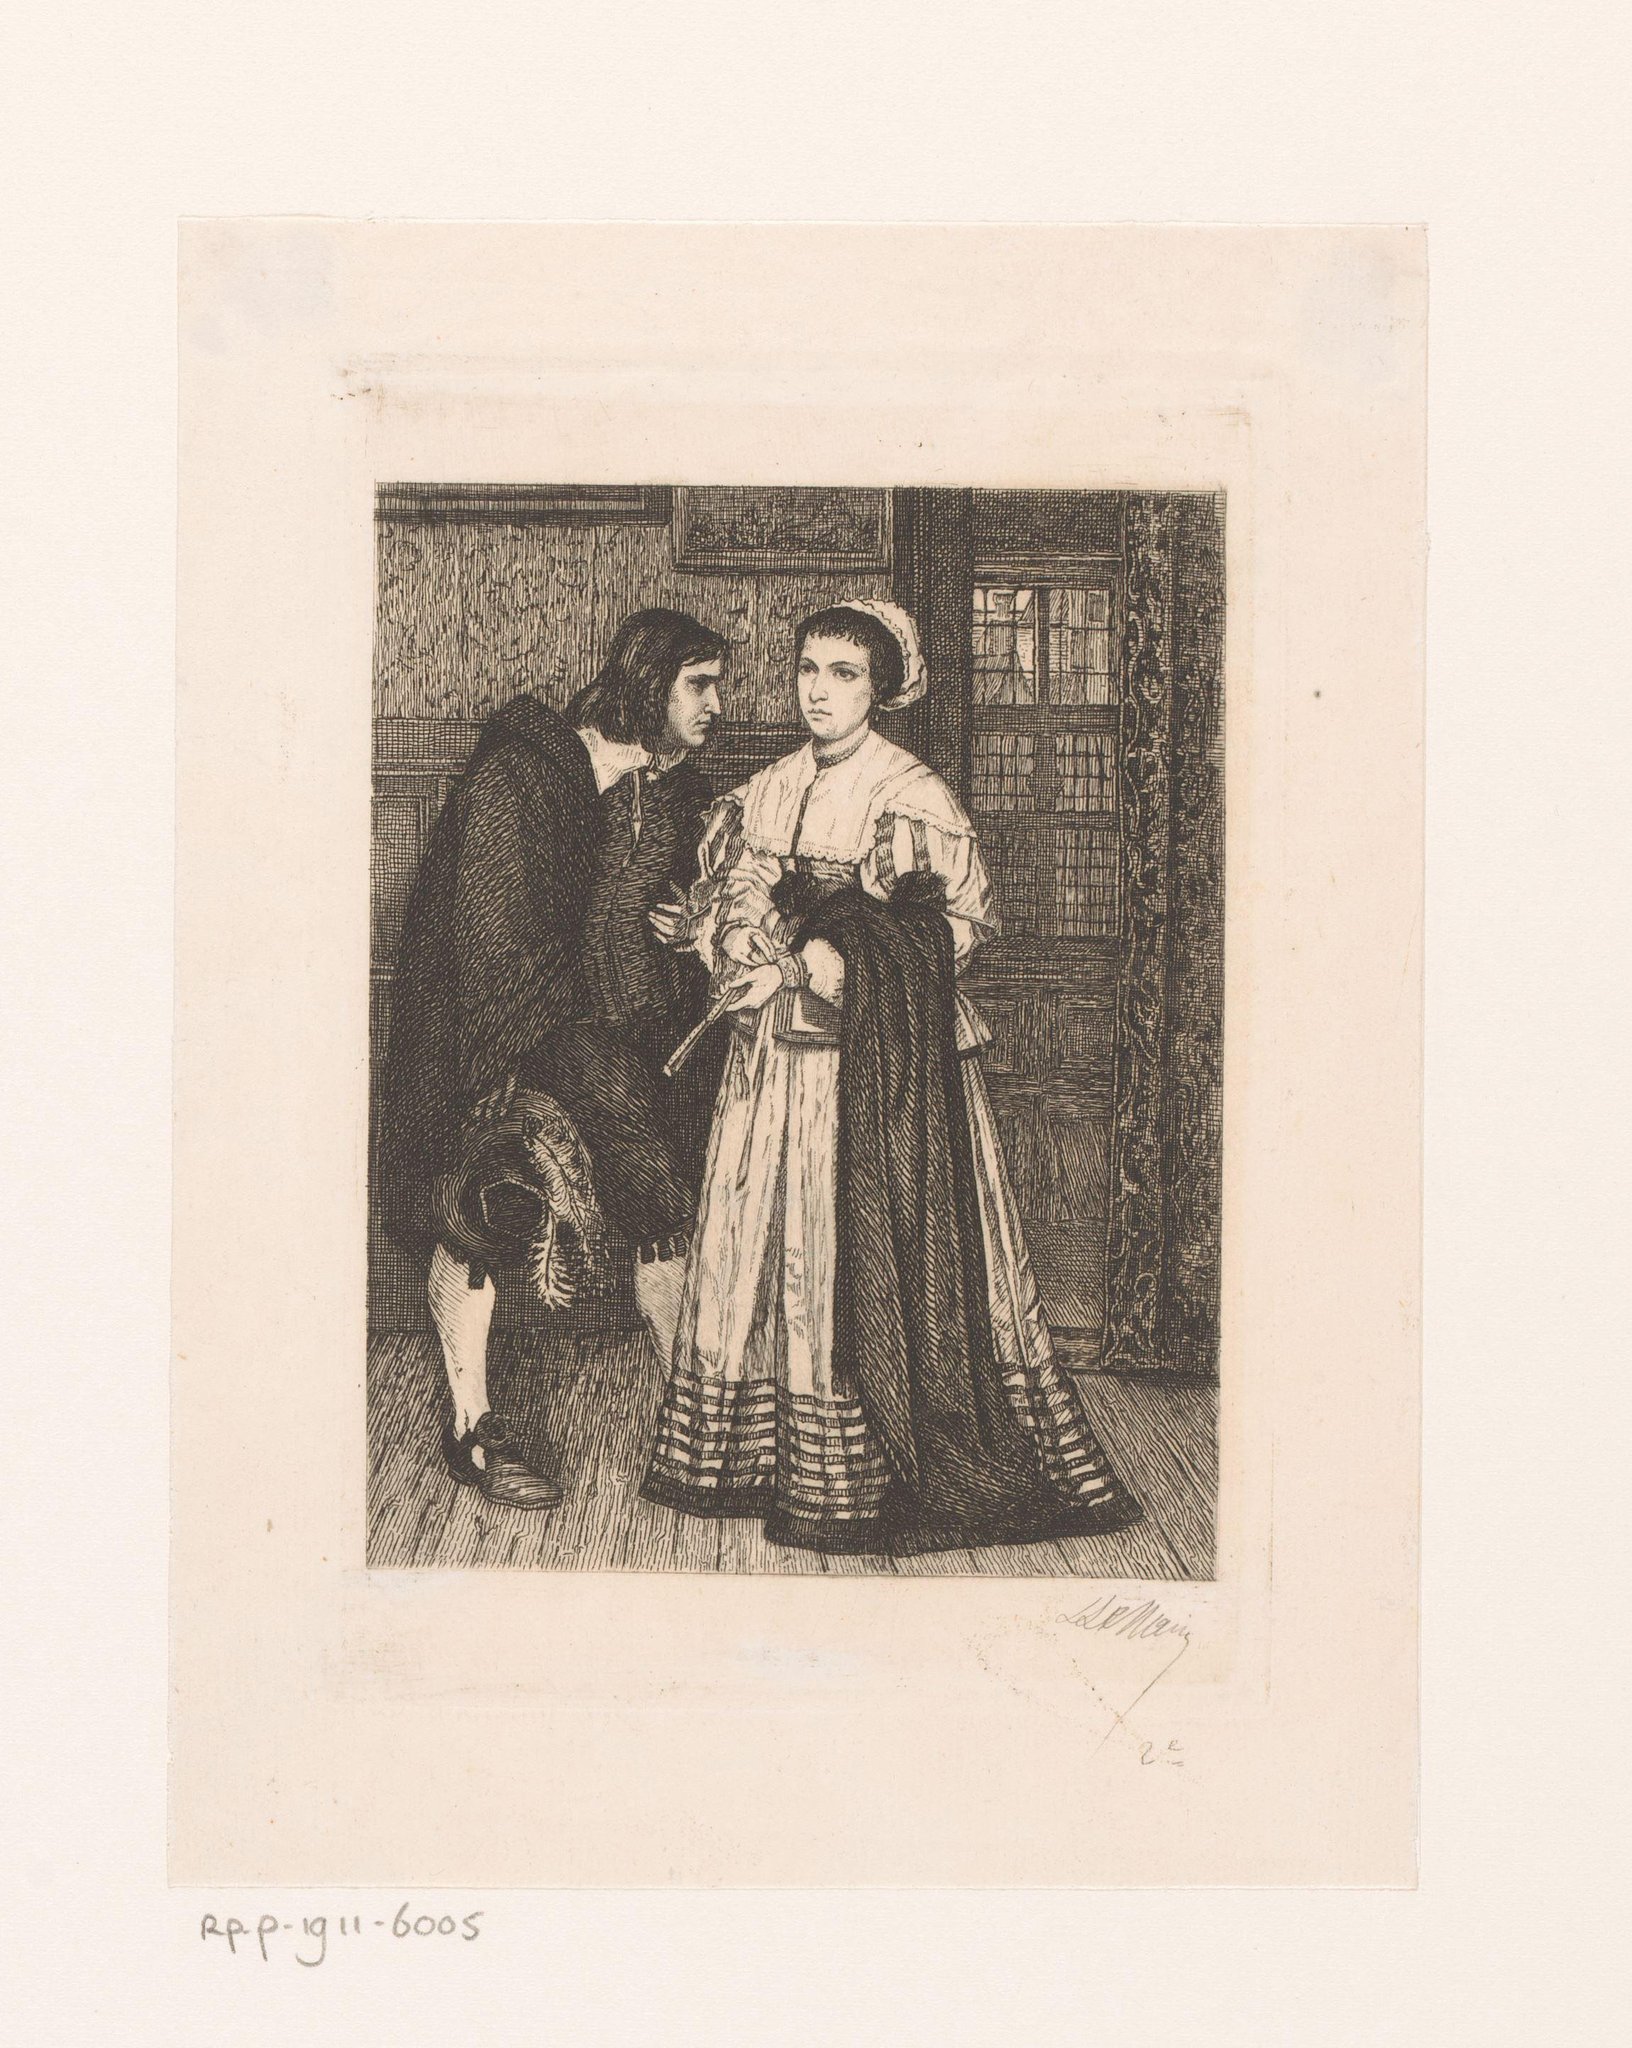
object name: print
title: Man neemt zijn hoed af voor een vrouw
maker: louis le nain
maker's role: print maker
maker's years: 1851-1939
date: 1863-1911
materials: paper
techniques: etching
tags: adult woman, adult man, historical costume, proposal, declaration of love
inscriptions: inscription: ‘LLeNain 2e’, collector's mark: Lugt 2228